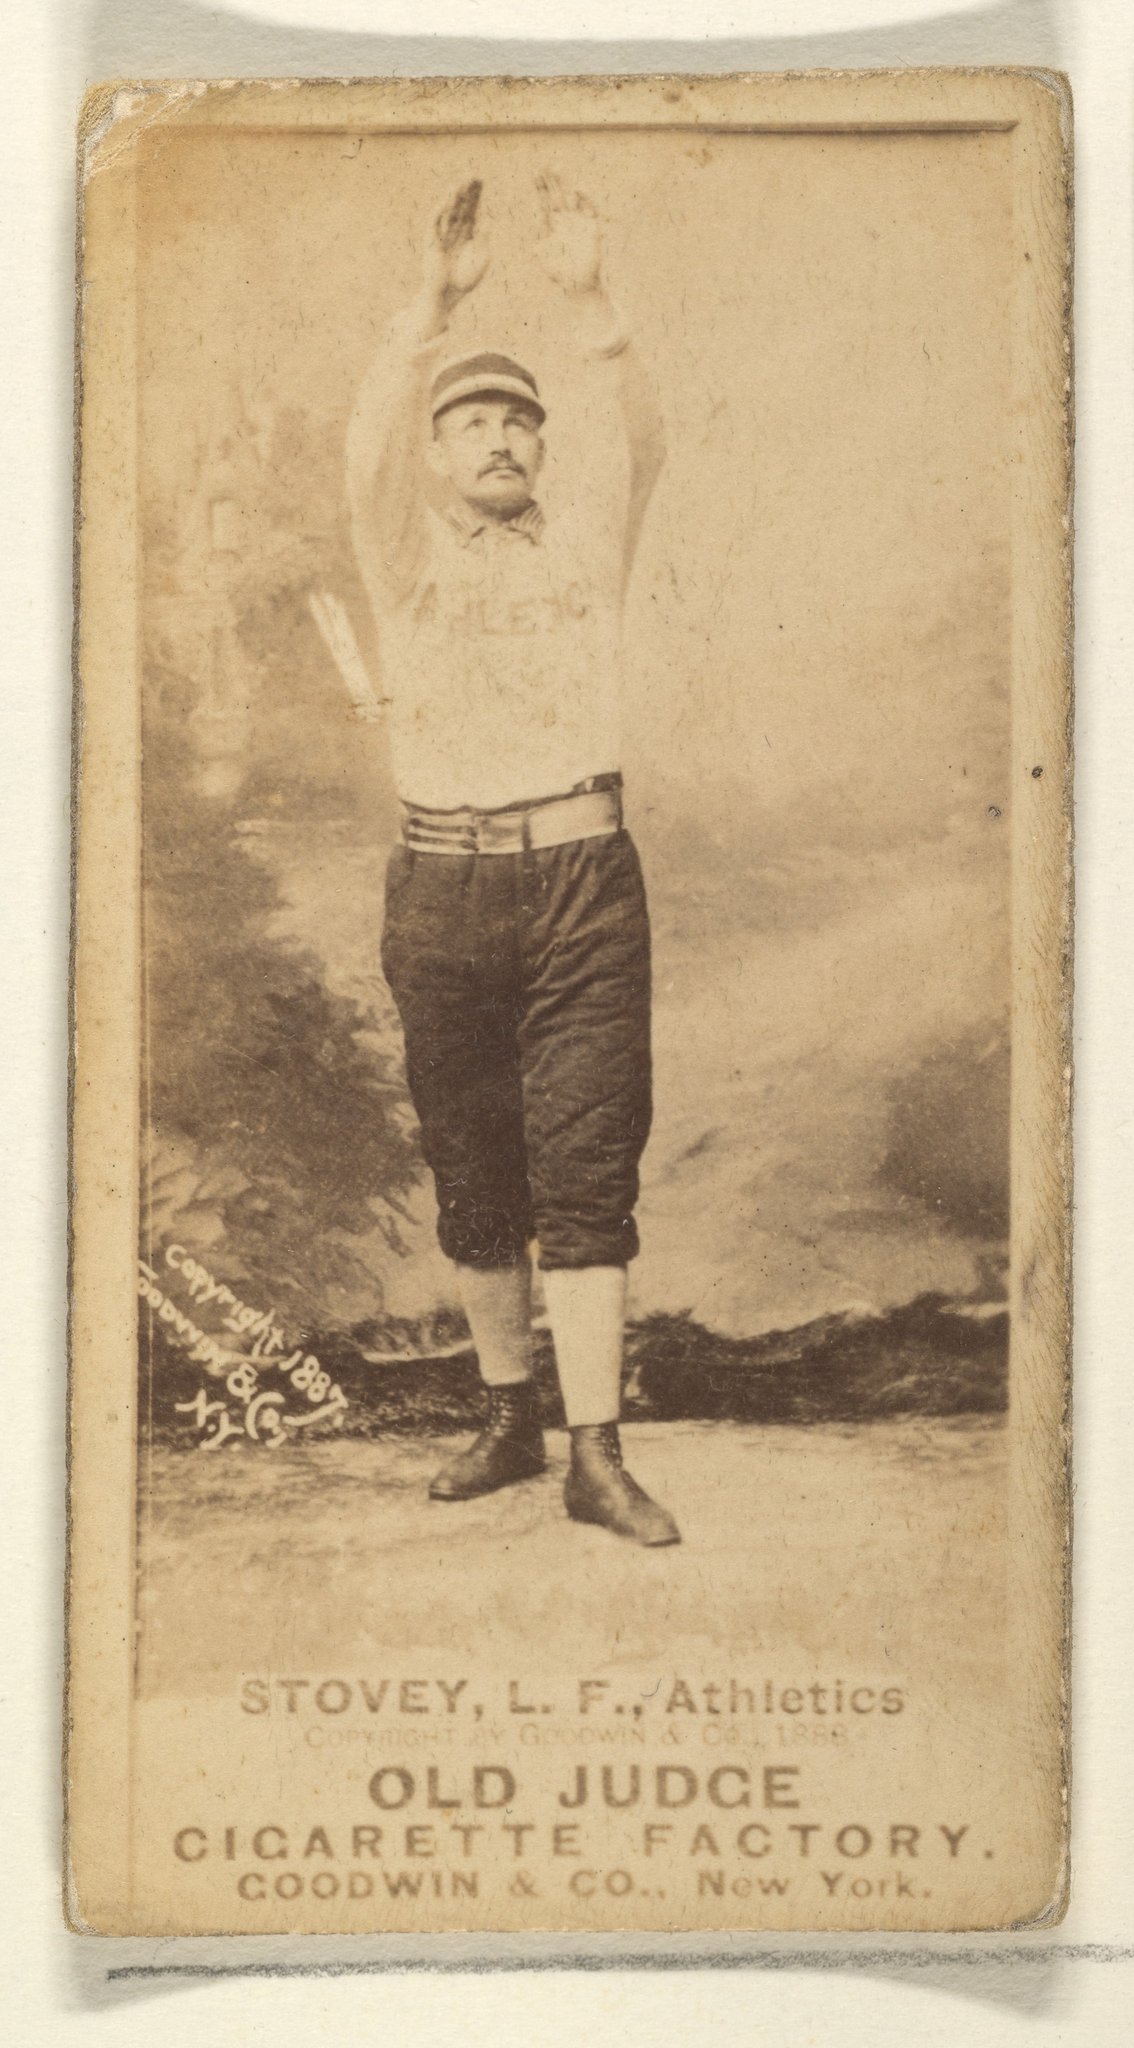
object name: baseball card, photograph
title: Stovey, Left Field, Philadelphia Athletics, from the Old Judge series (N172) for Old Judge Cigarettes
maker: goodwin & company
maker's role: publisher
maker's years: 1850-1950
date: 1887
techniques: albumen silver print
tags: men,portraits,baseball,athletes